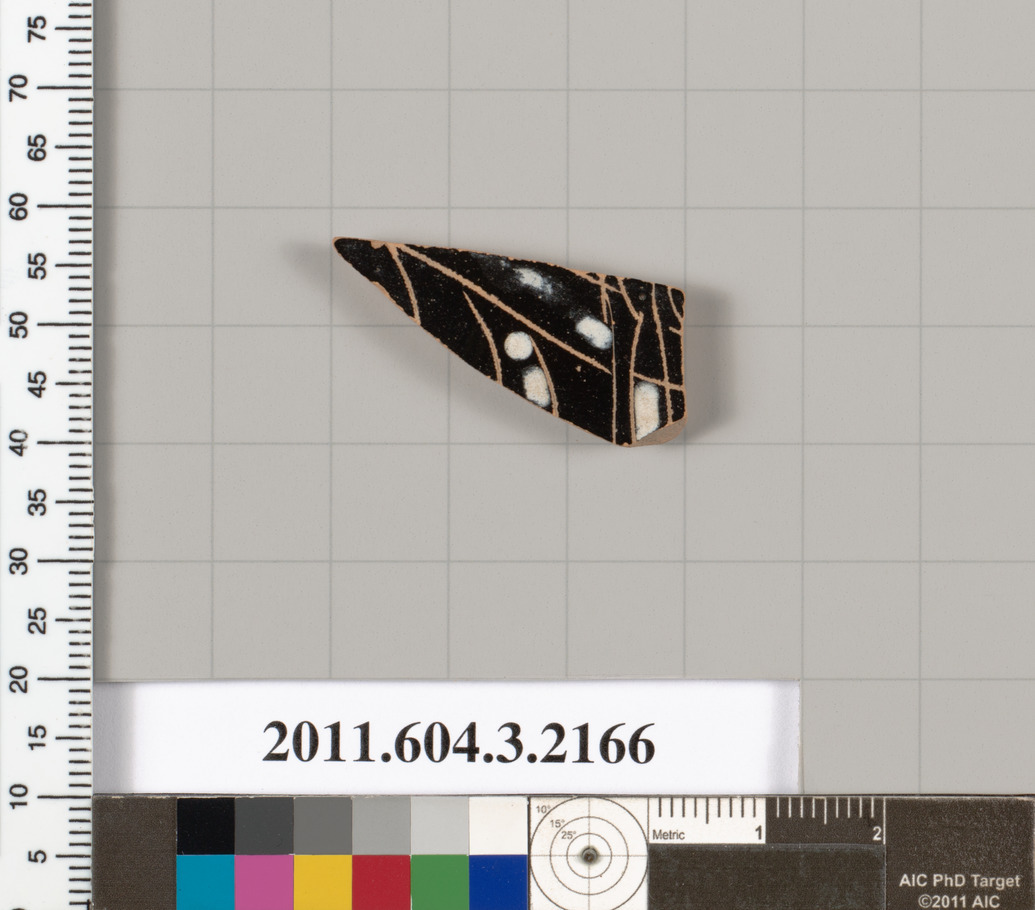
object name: kylix fragment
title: Terracotta fragment of a kylix (drinking cup)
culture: greek, attic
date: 525-501 BCE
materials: terracotta